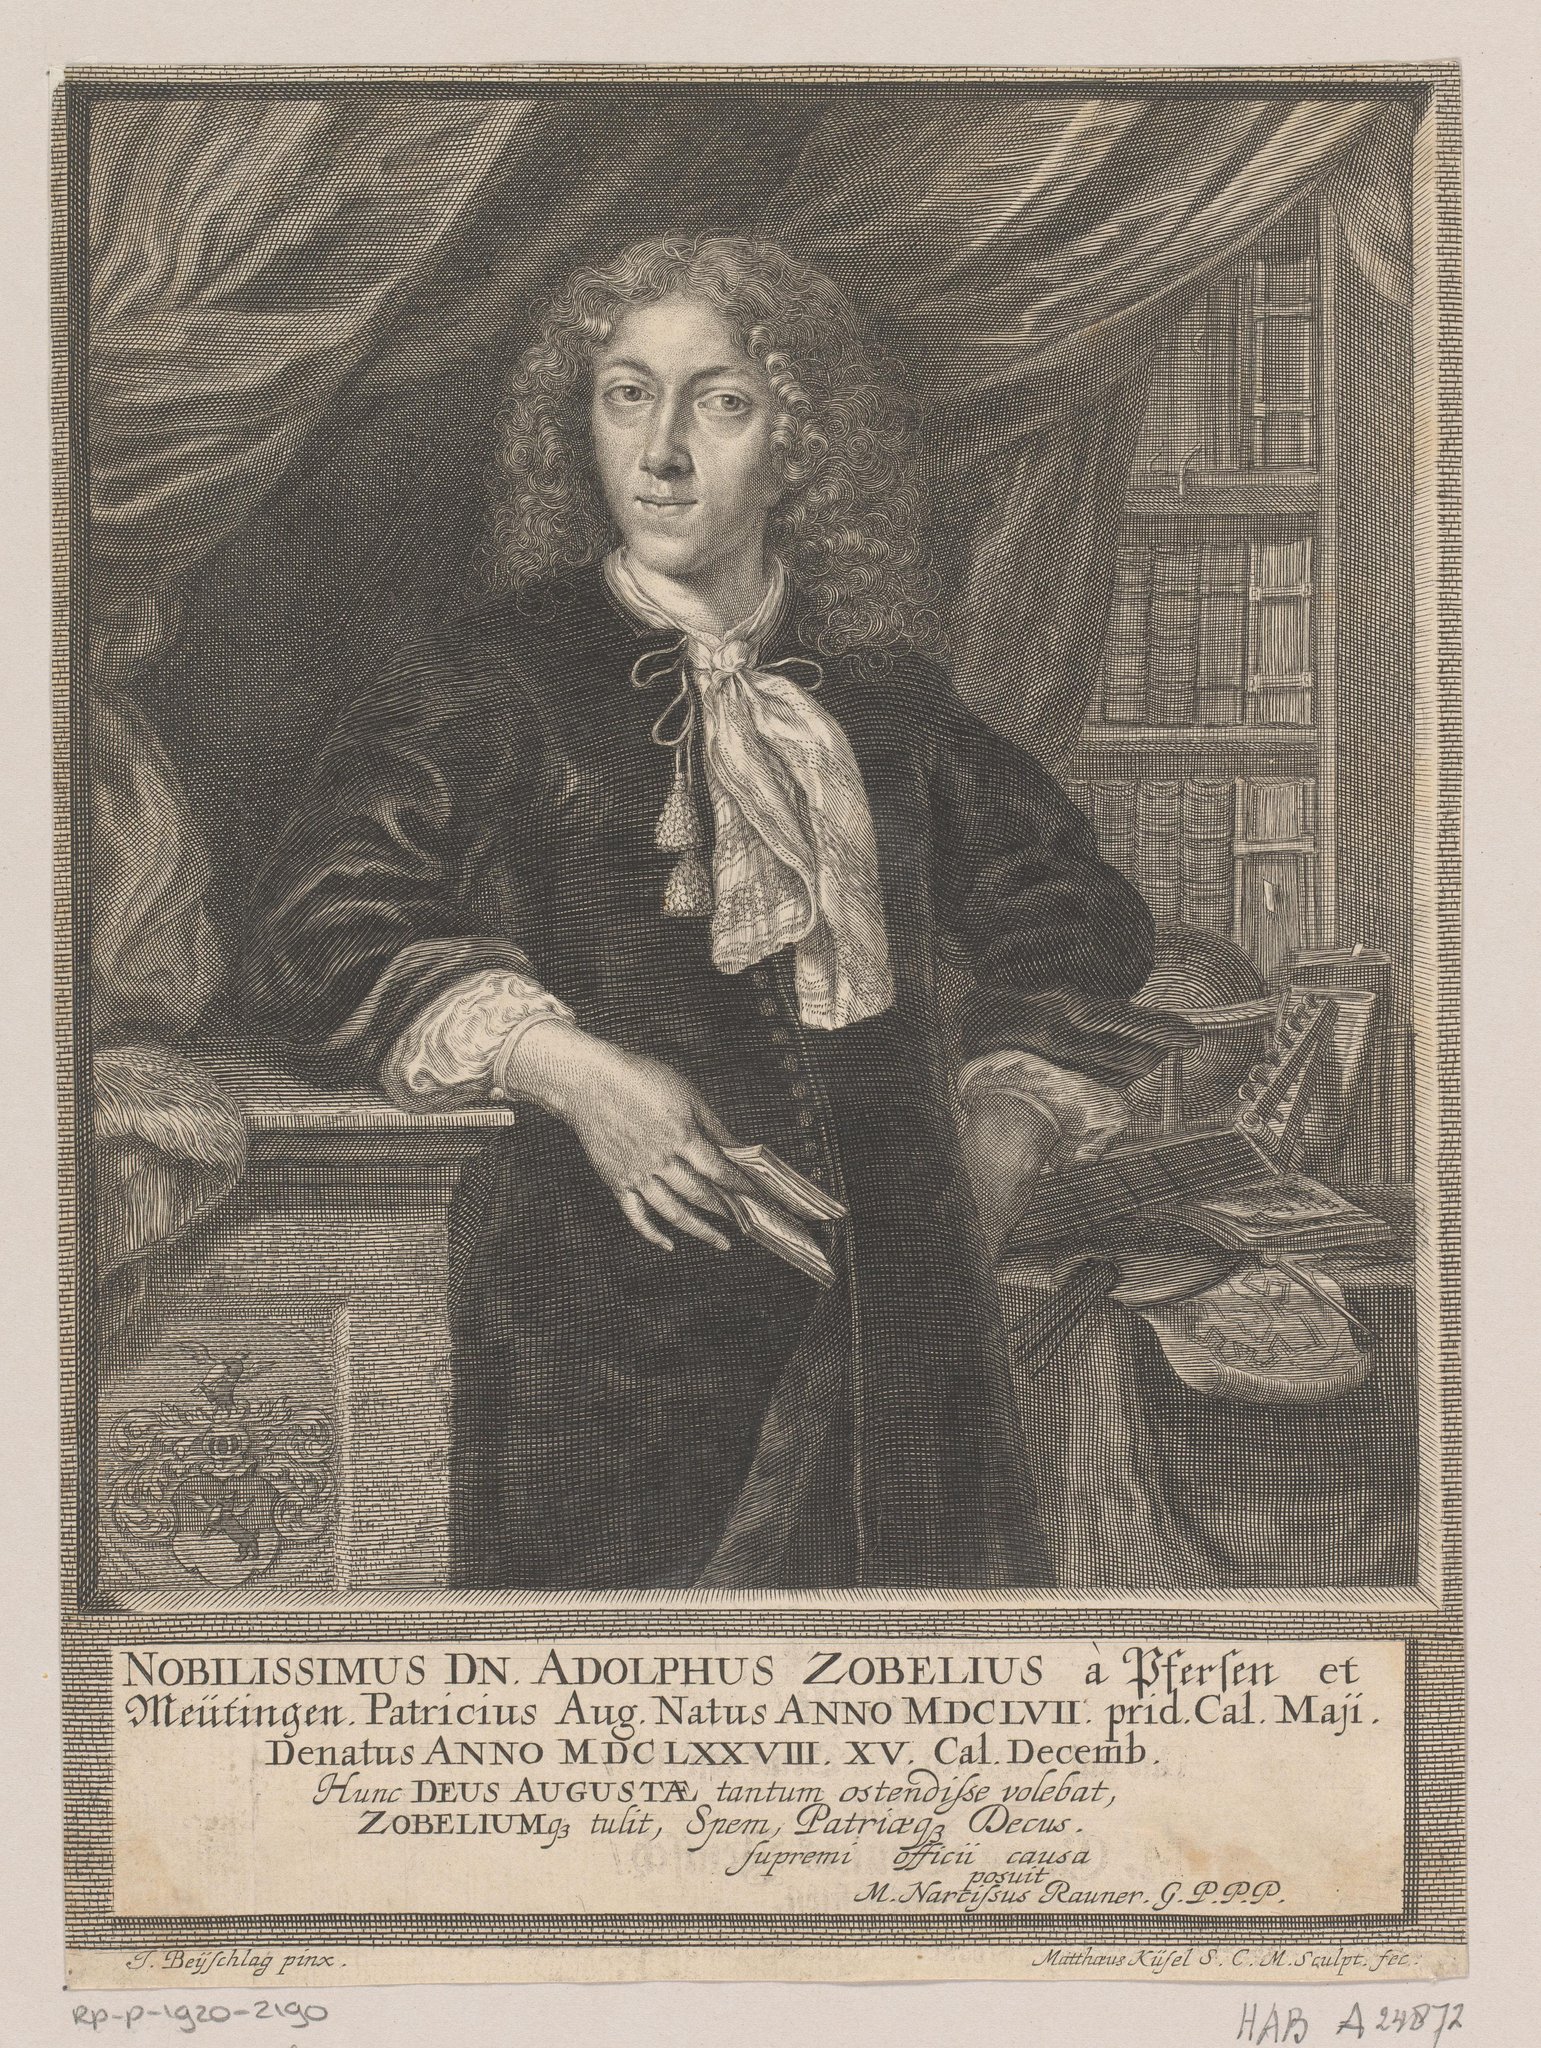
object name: print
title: Portret van Adolph Zobel von Pfersen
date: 1678-1681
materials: paper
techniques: engraving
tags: augsburg, historical persons, armorial bearing, heraldry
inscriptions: collector's mark: Lugt 2228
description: Met zesregelig onderschrift in het Latijn.